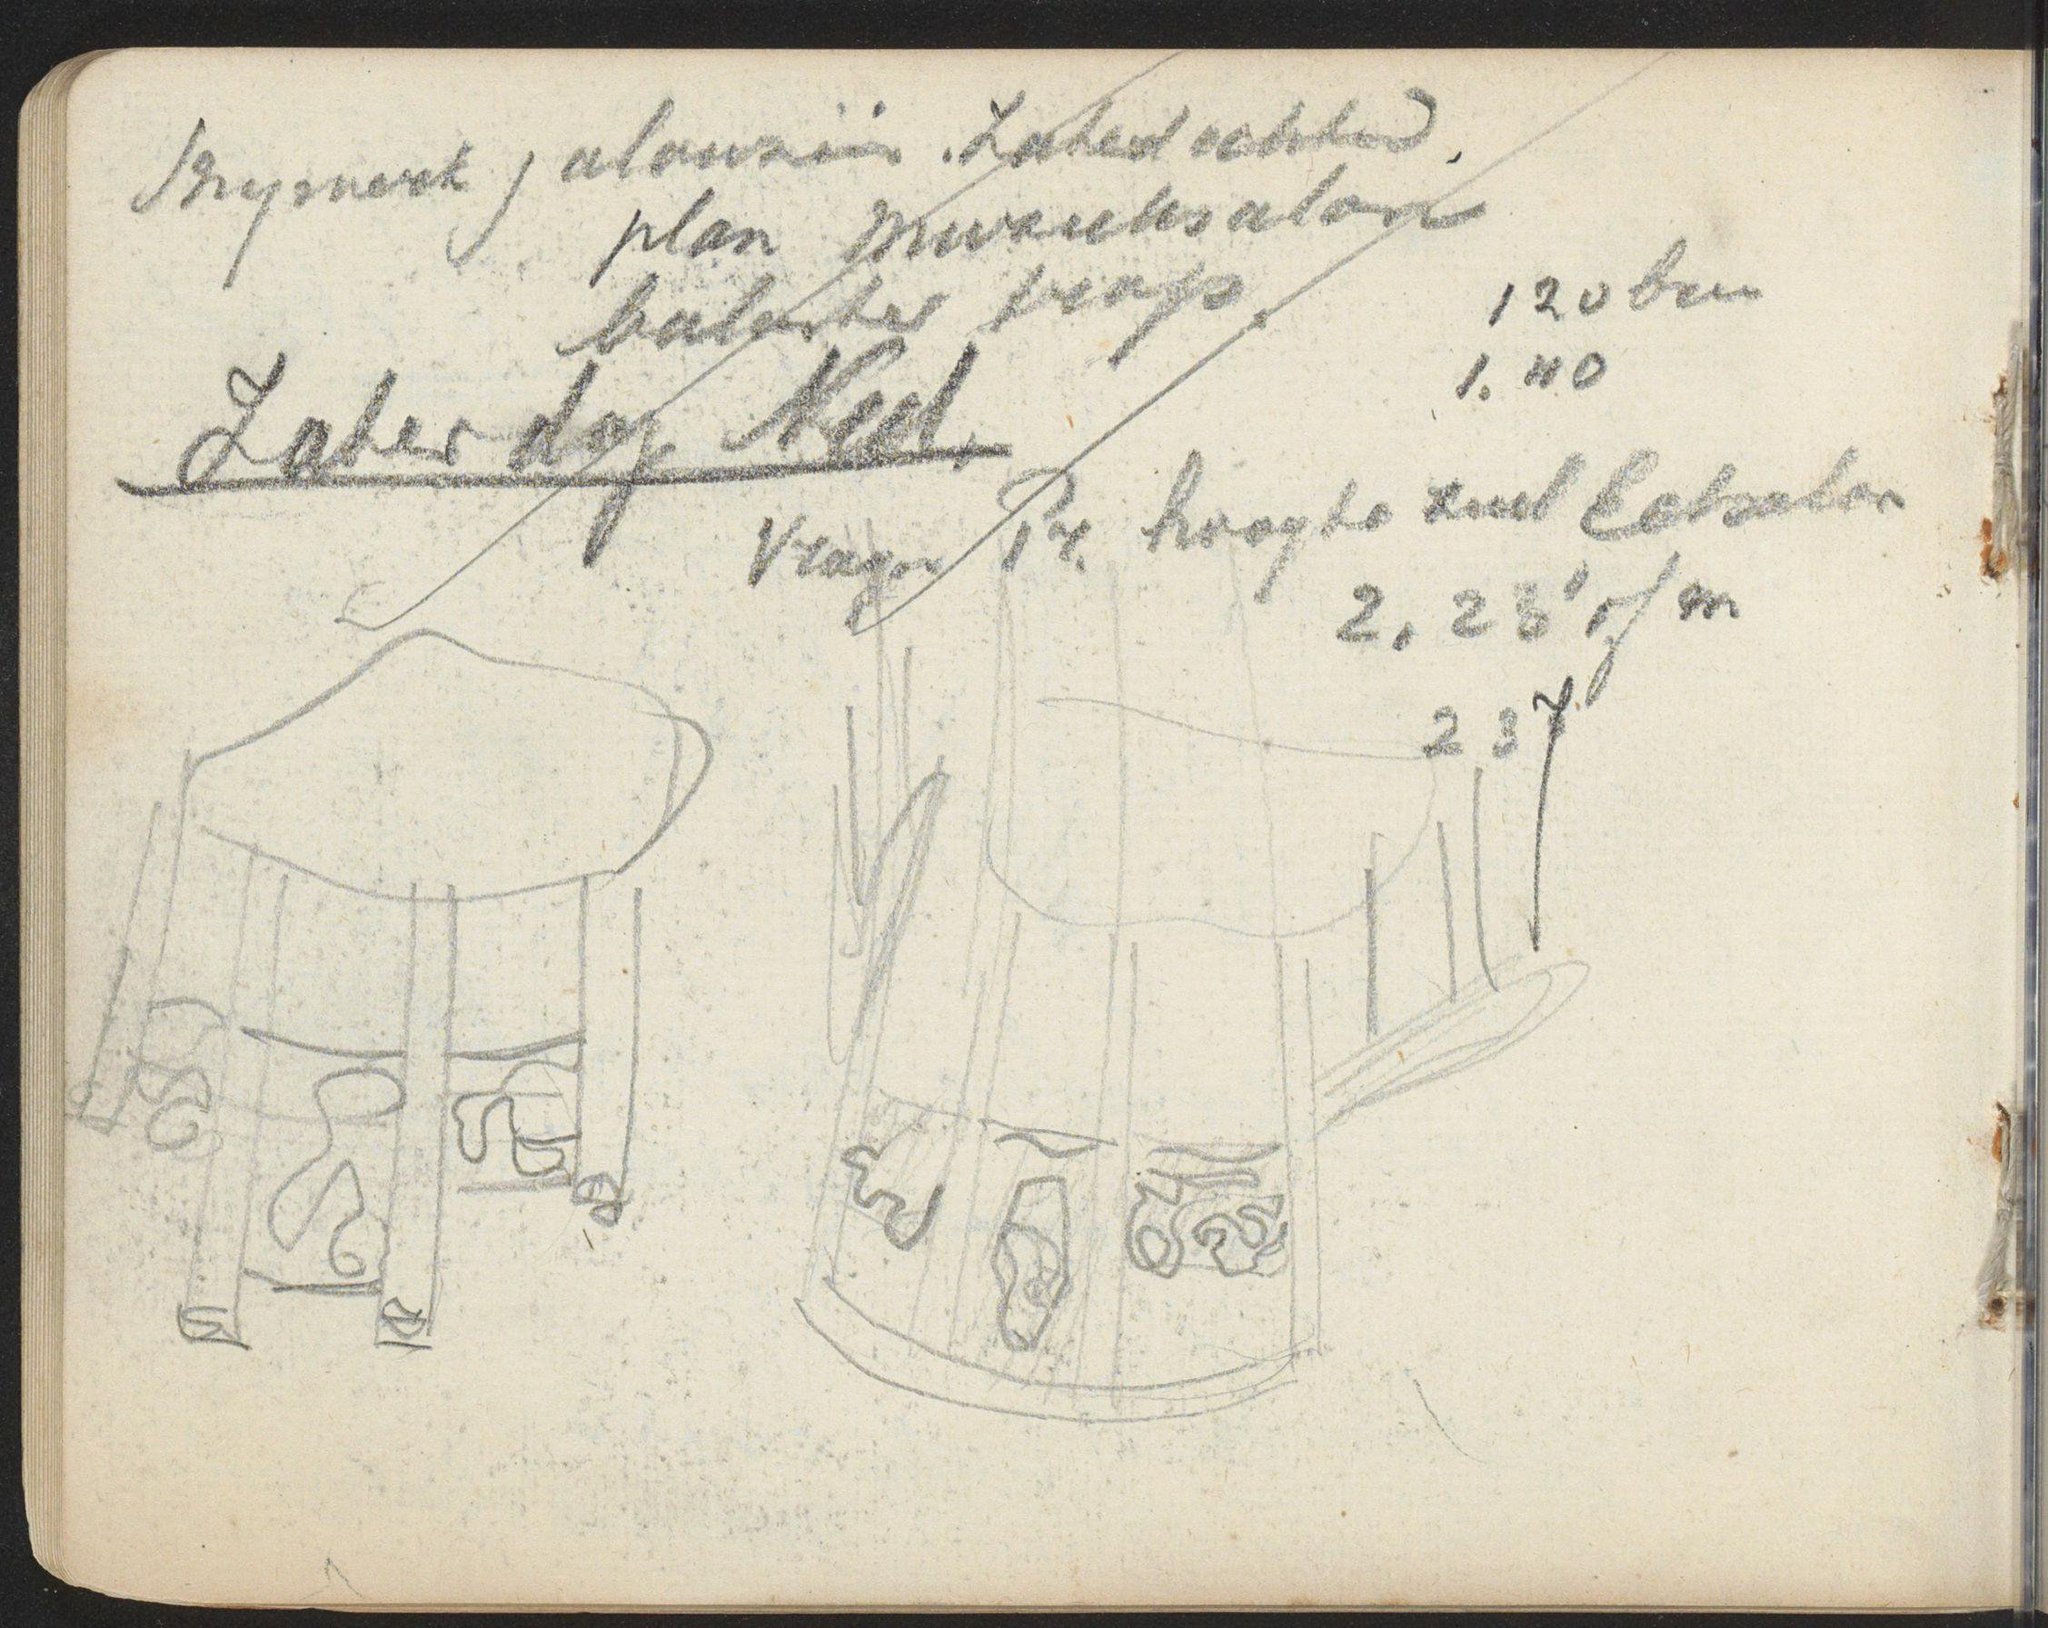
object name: sketchbook leaf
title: Ontwerpen voor een stoel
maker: carel adolph lion cachet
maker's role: draughtsman, print maker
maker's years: 1864-1945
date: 1928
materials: paper, pencil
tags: chair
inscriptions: annotation: ‘[...]/ plan muzieksalon/ [...]’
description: Blad 12 verso uit een schetsboek met 24 bladen.